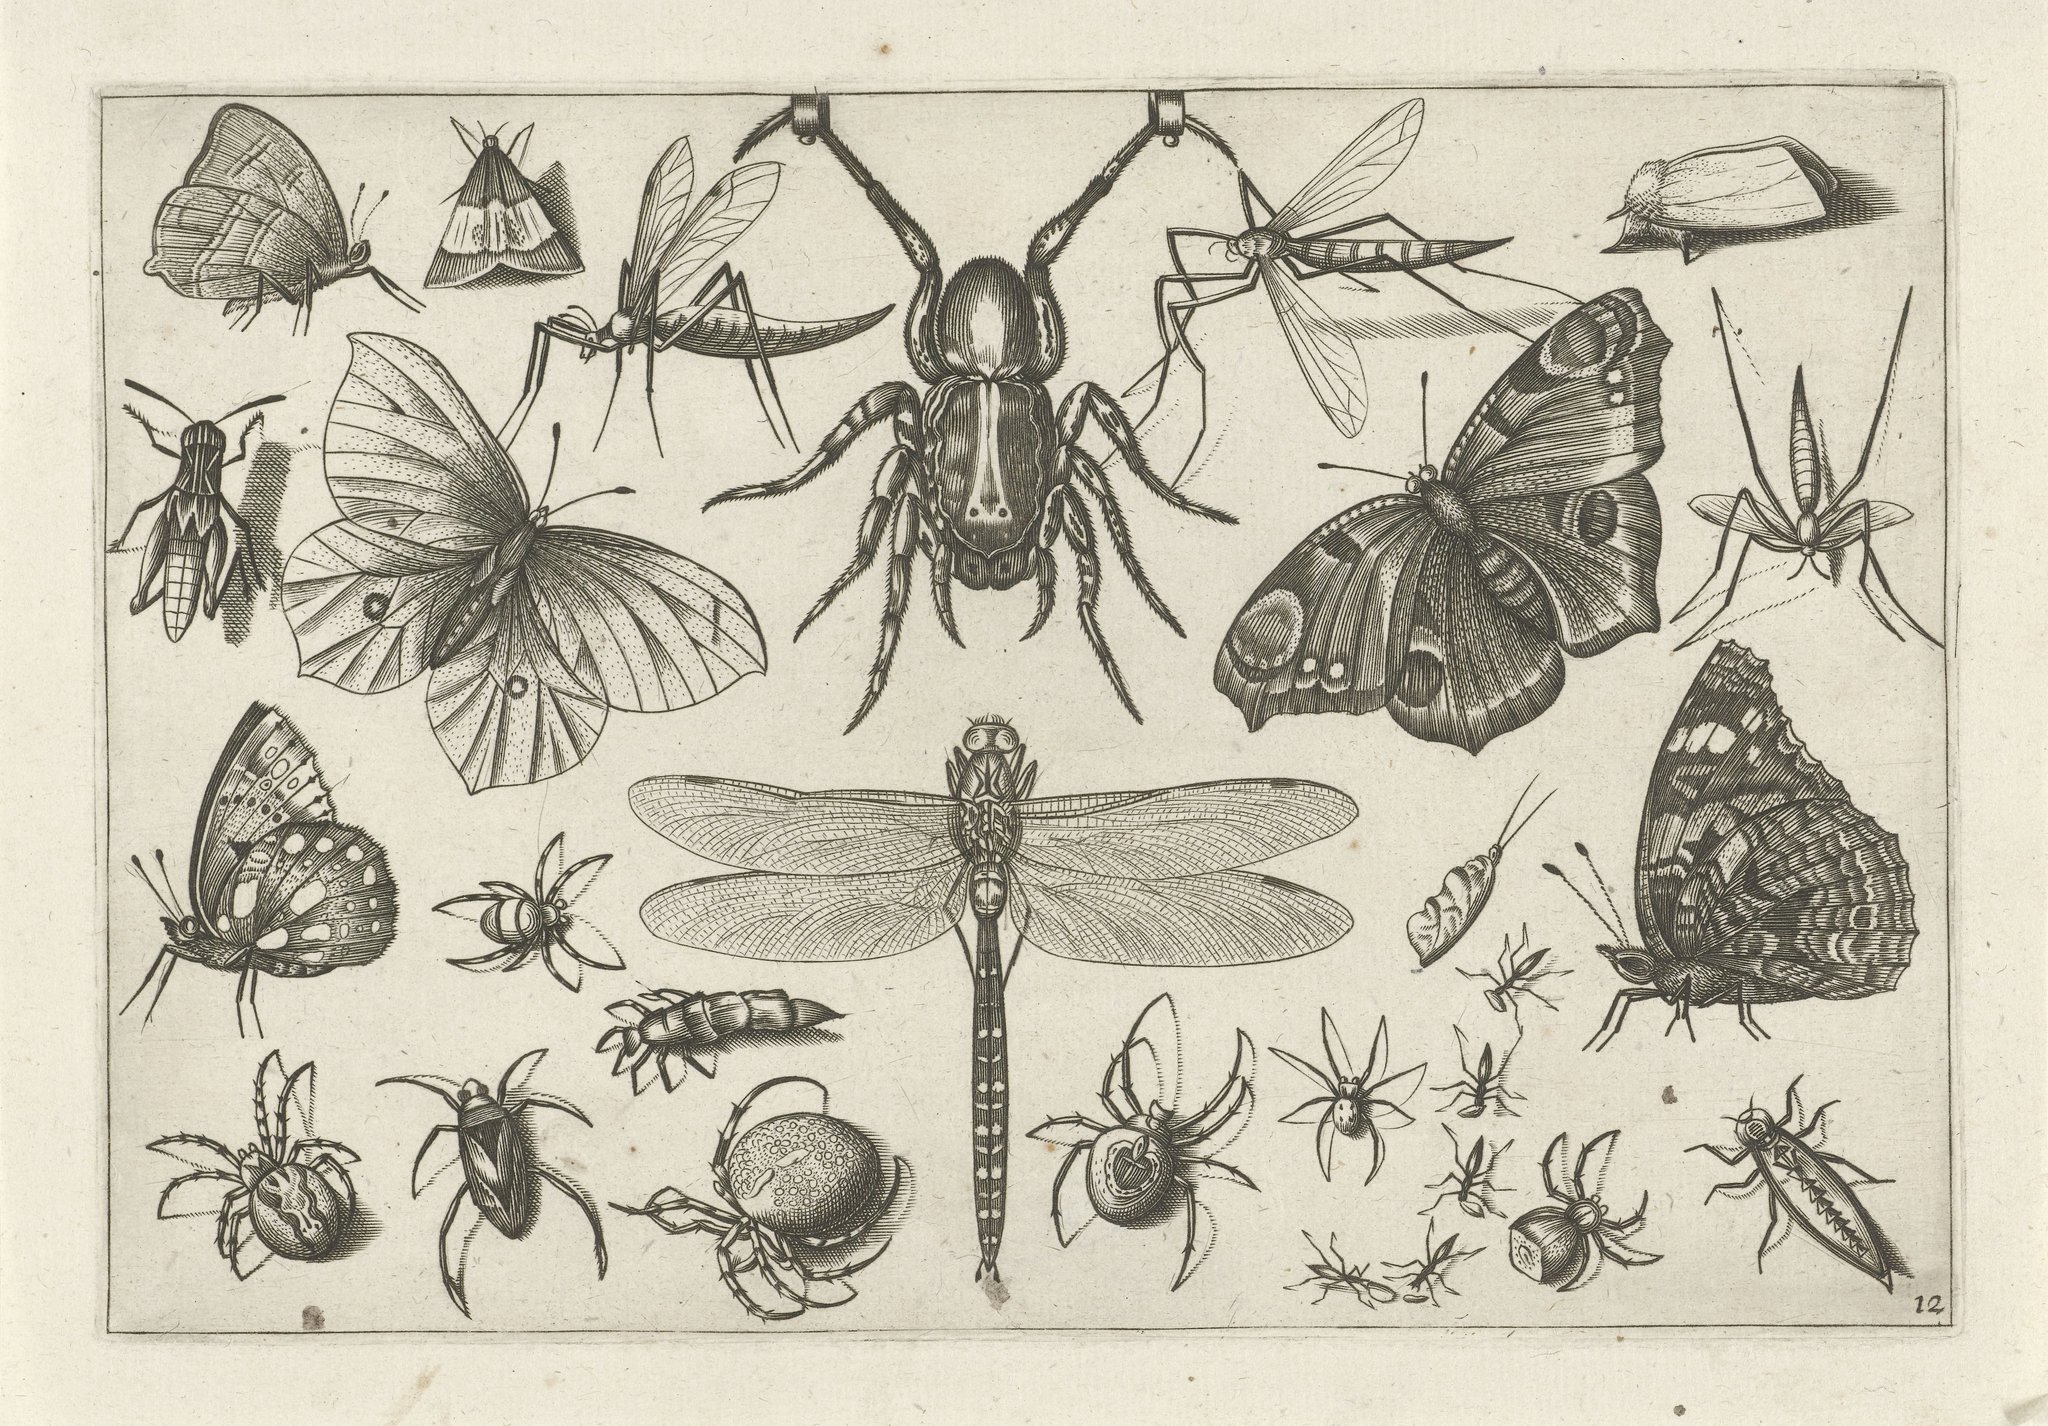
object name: print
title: Insecten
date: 1630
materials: paper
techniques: engraving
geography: low countries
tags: insects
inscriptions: collector's mark: Lugt 2228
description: Verschillende insecten met middenboven een hangende spin.